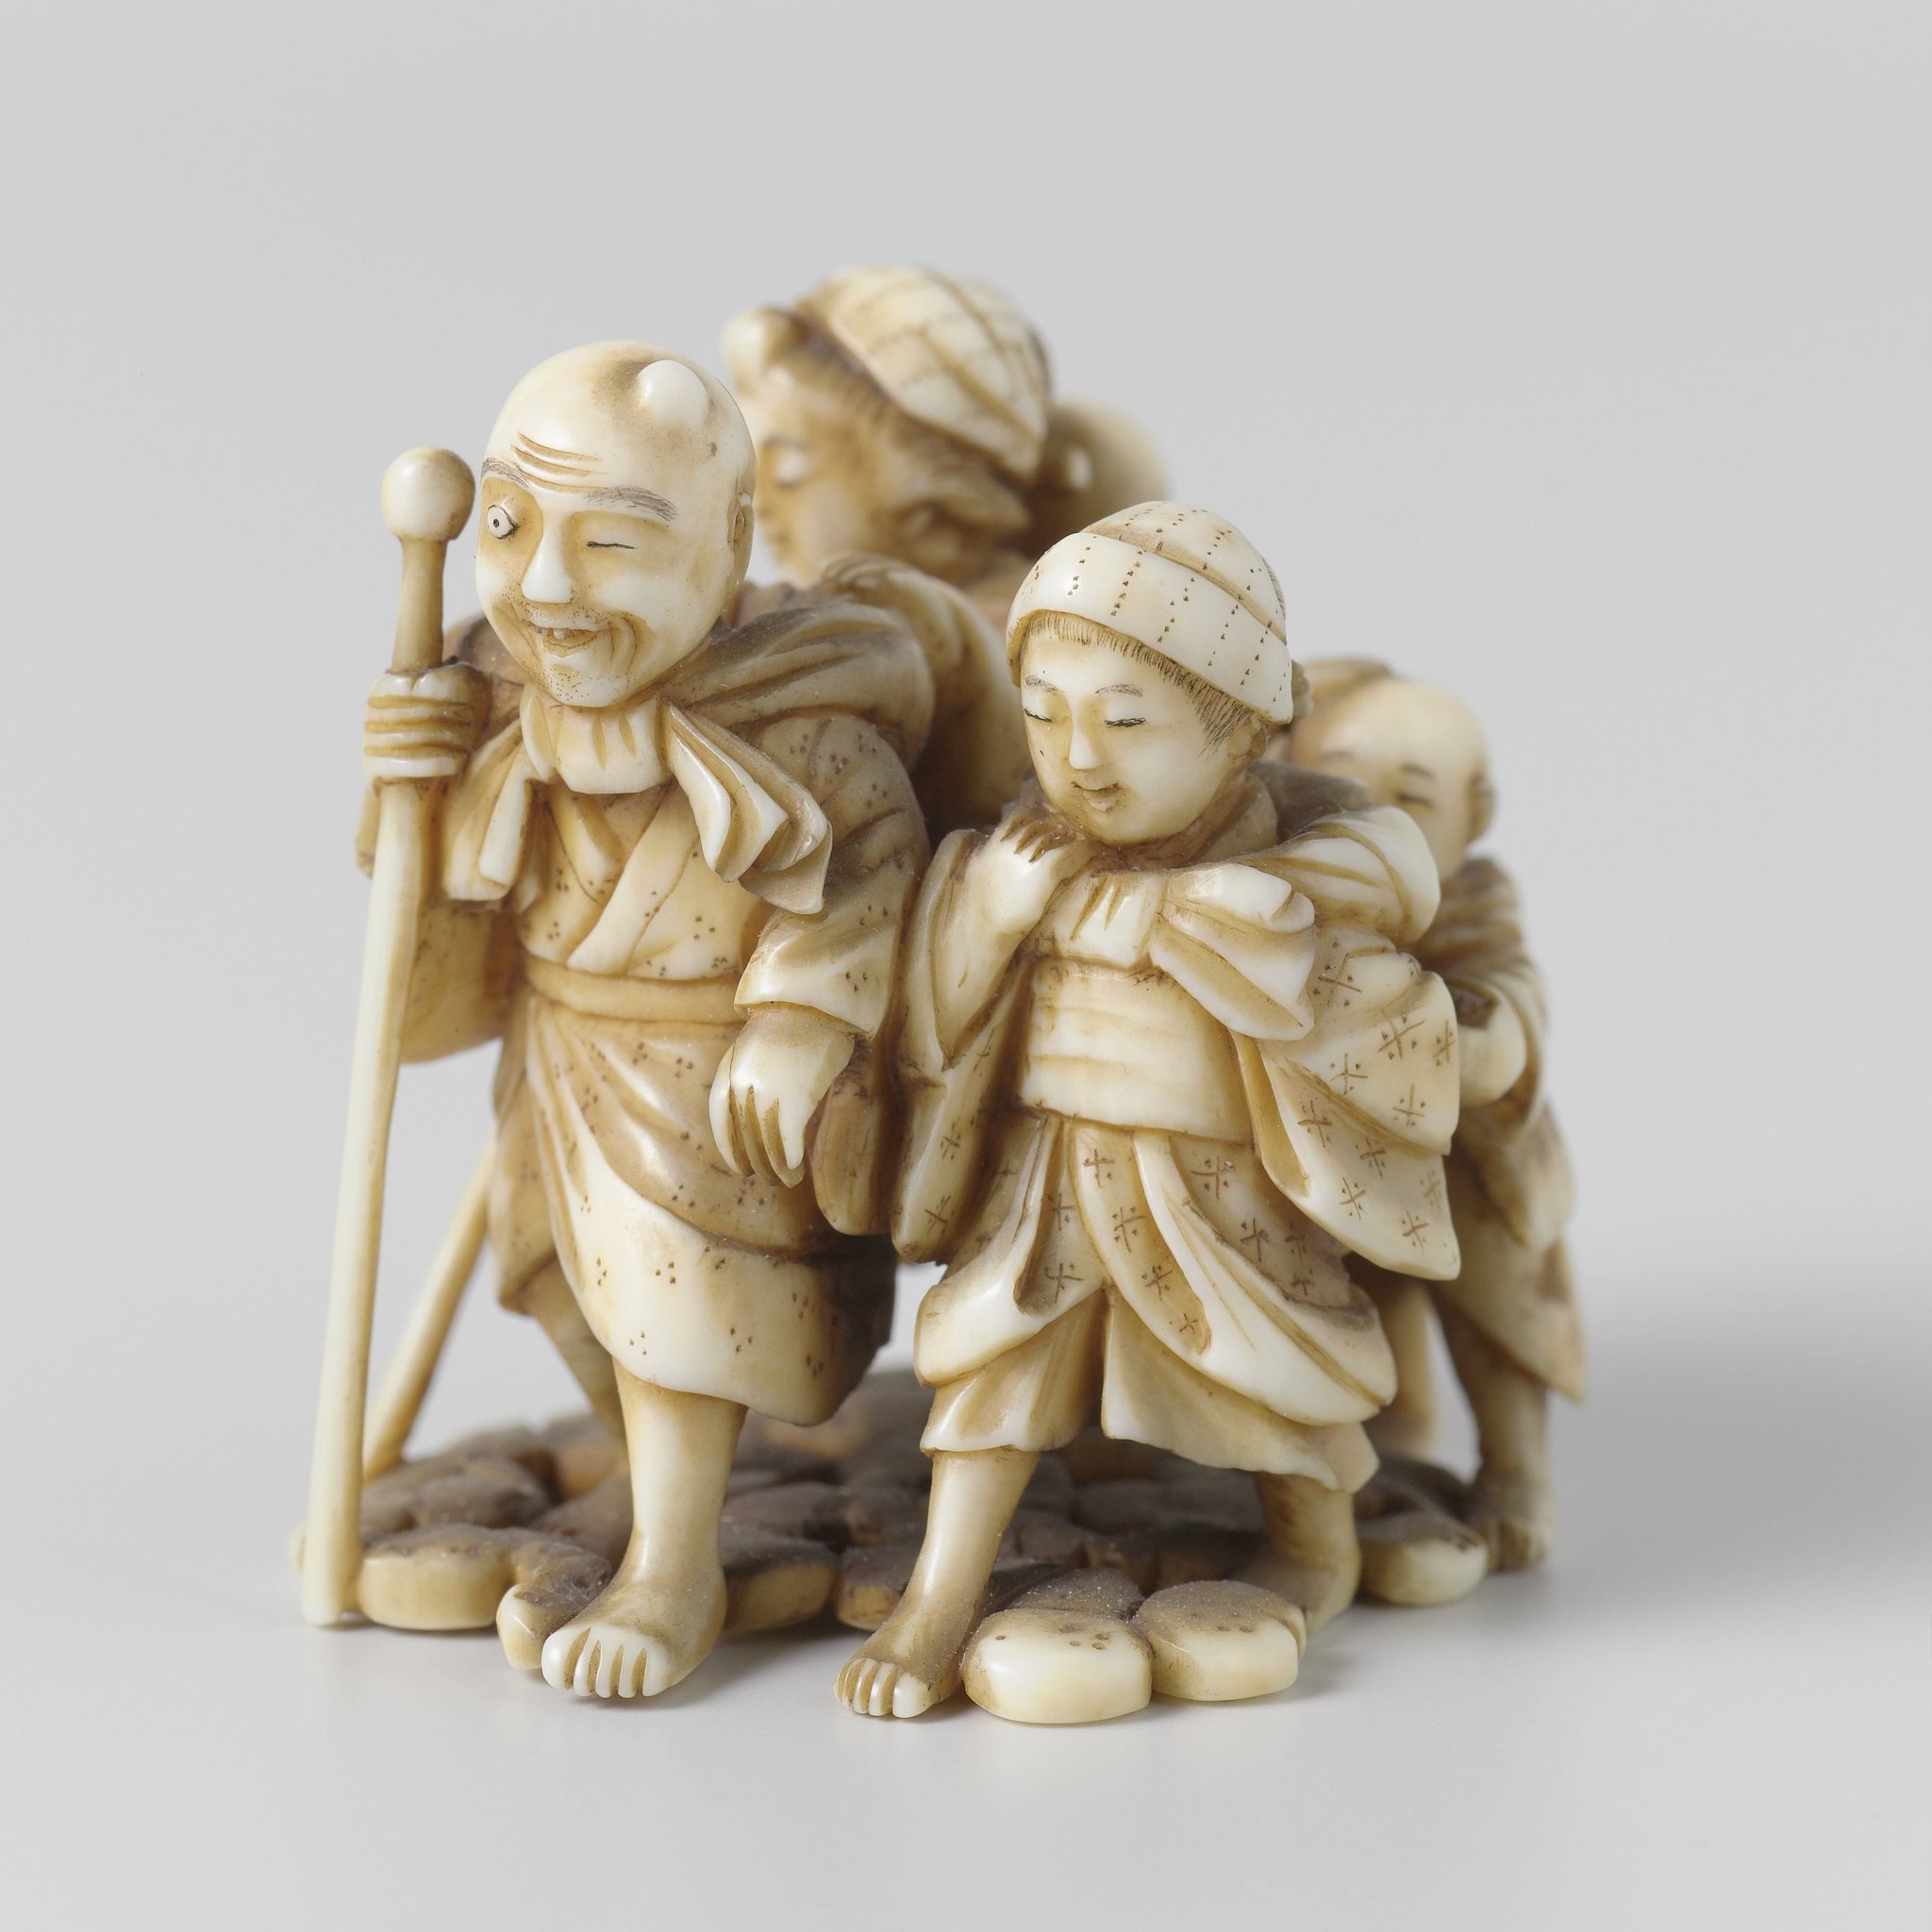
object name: netsuke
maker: Anonymous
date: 1700-1900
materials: ivory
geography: japan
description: Een groepje van vijf personen (famile?). Tussen hun ongeschoeide voeyten liggen kiezels - op een daarvan (aan de onderkant) staat een inscriptie.